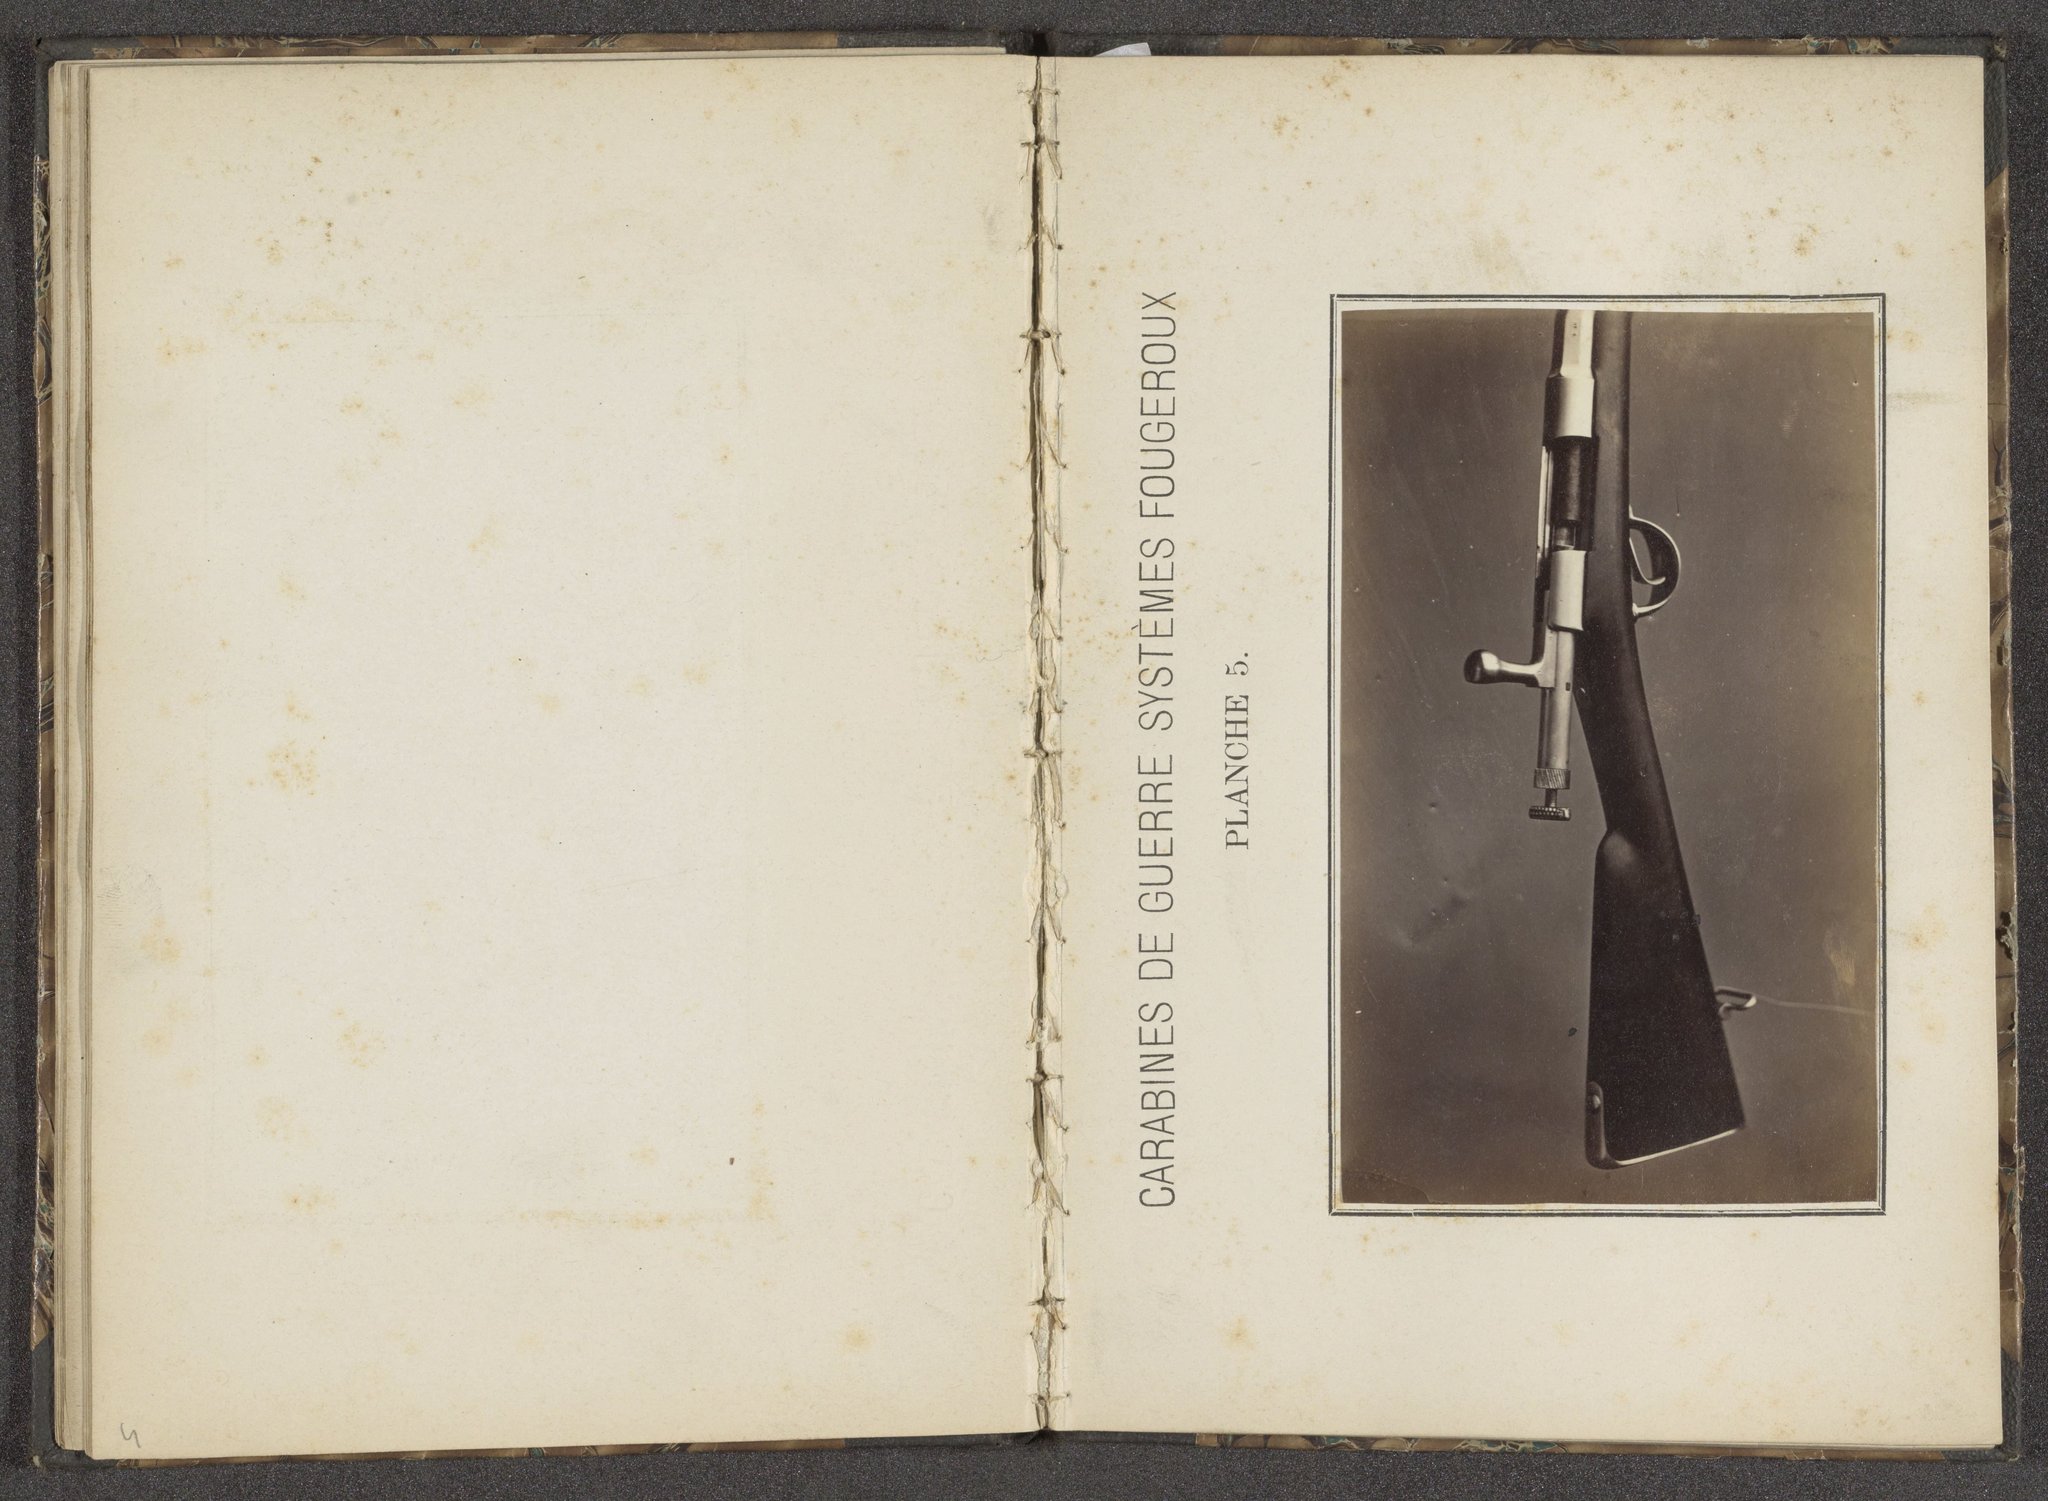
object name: page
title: Kolf van een geweer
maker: edouard magis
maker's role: fotograaf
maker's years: 1828-1906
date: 1857-1867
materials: photographic support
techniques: albumen print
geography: liège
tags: firearms: rifle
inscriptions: number: ‘Planche 5.’, inscription: ‘Carabines de guerres systèmes Fougeroux’